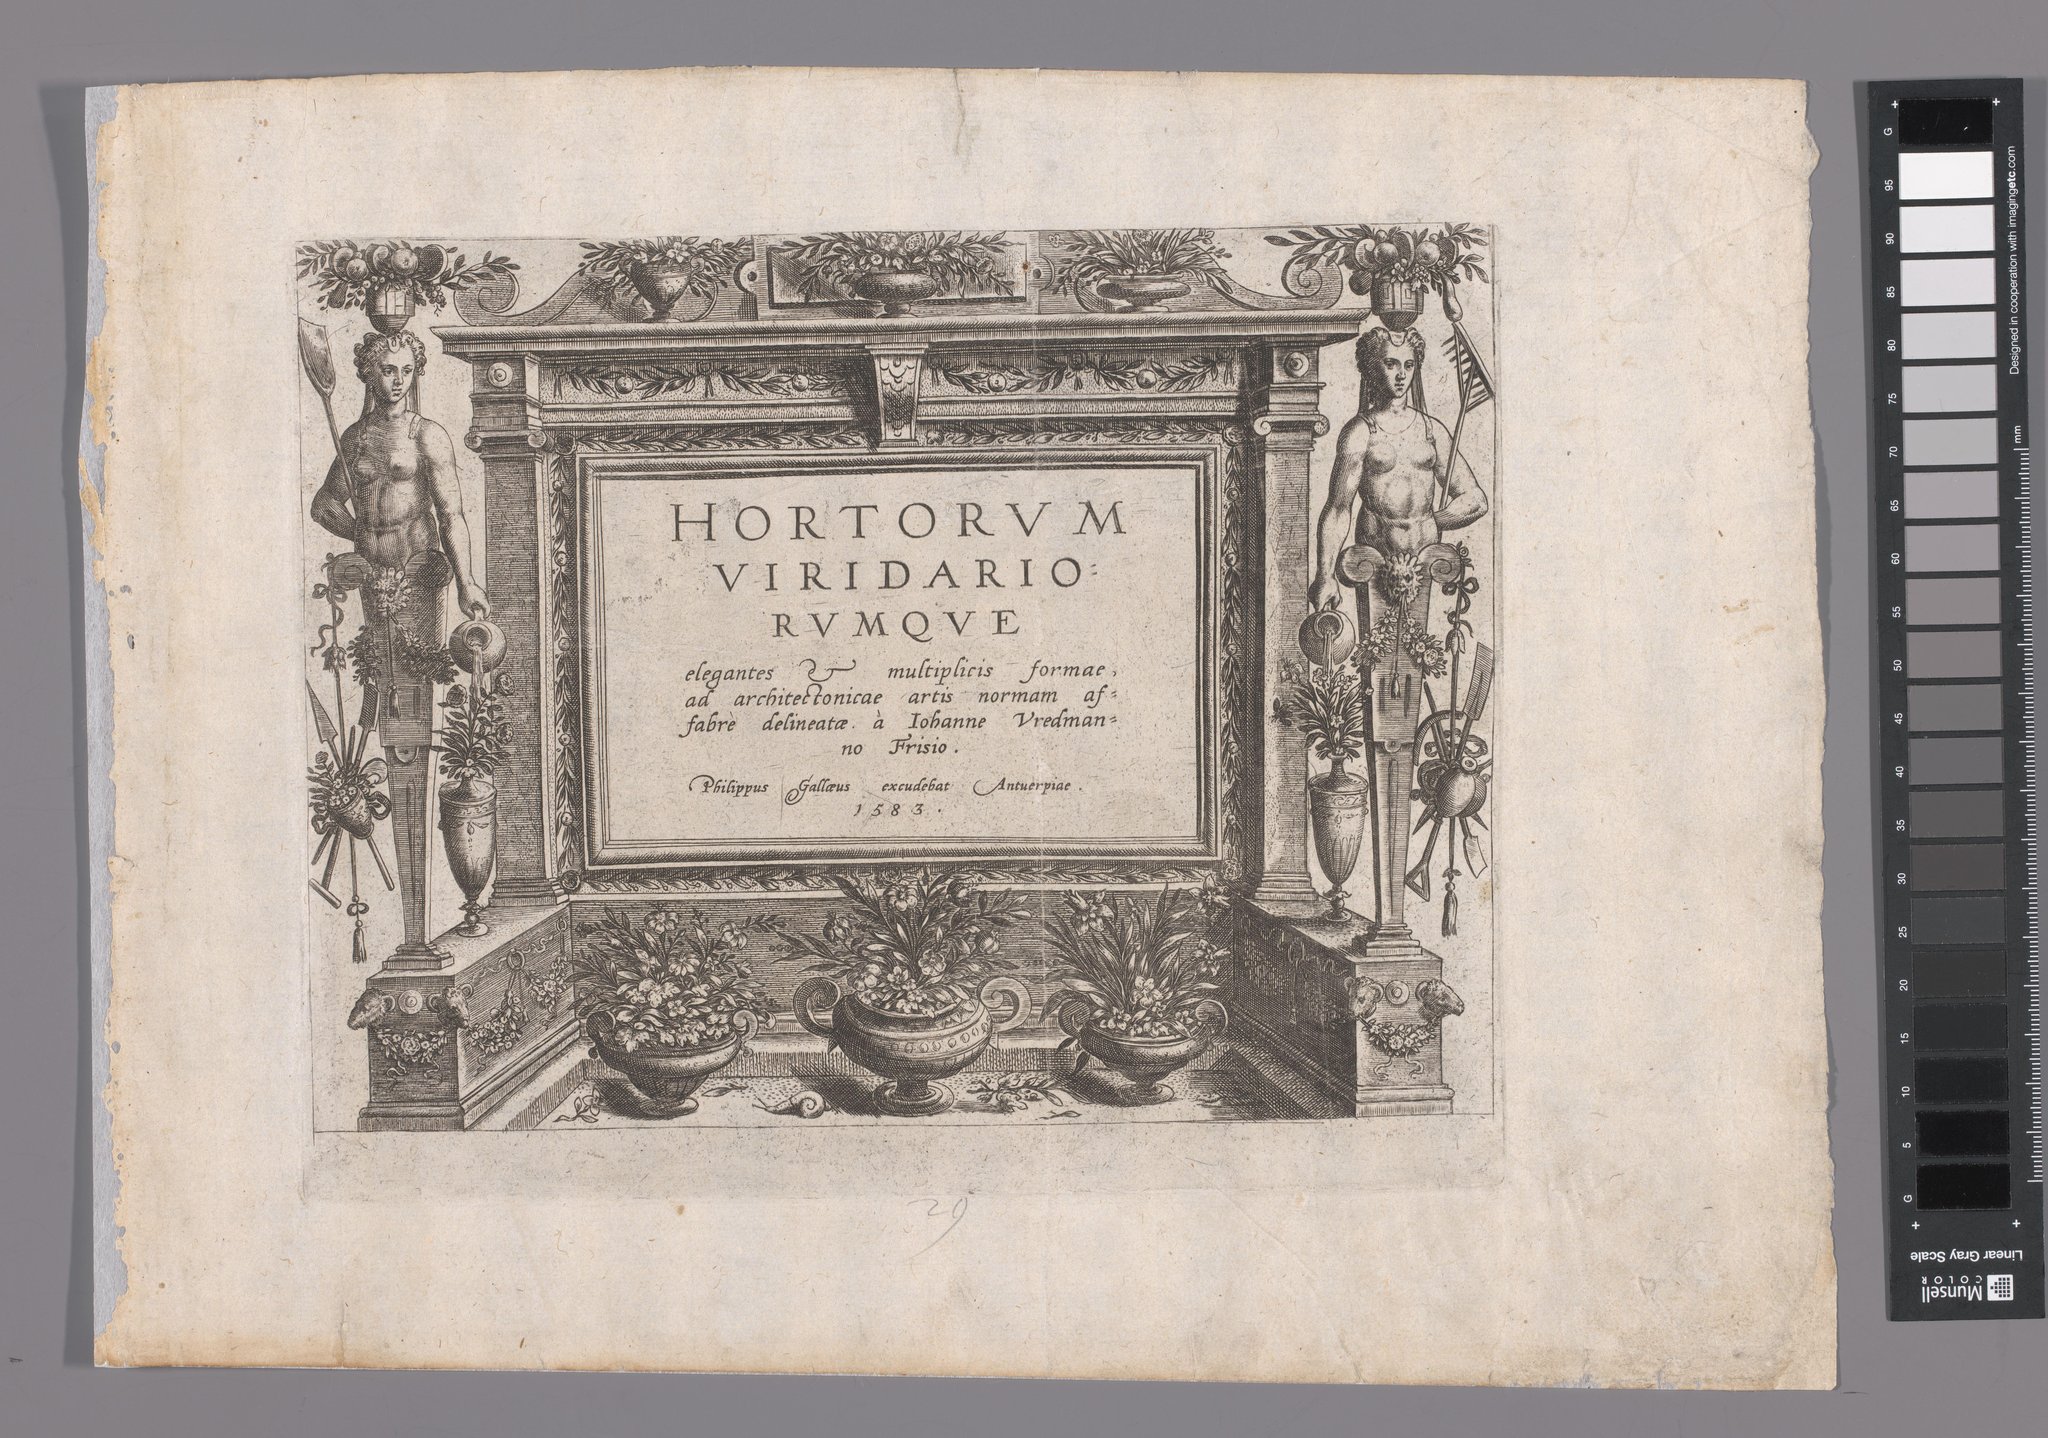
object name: titelprent, frontispice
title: Tuinontwerpen geassocieerd met de Dorische, Ionische en Korinthische bouworden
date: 1583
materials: paper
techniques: etching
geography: antwerp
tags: garden, french or architectonic garden; formal garden, labyrinth, maze ~ garden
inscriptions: date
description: Een ornamentele plaat met de titel geflankeerd door vrouwelijke hermen met tuingereedschap. Onderaan drie vazen met bloemen en een slak. Titelprent voor een serie tuinontwerpen volgens de Dorische, Ionische en Korinthische bouworden.